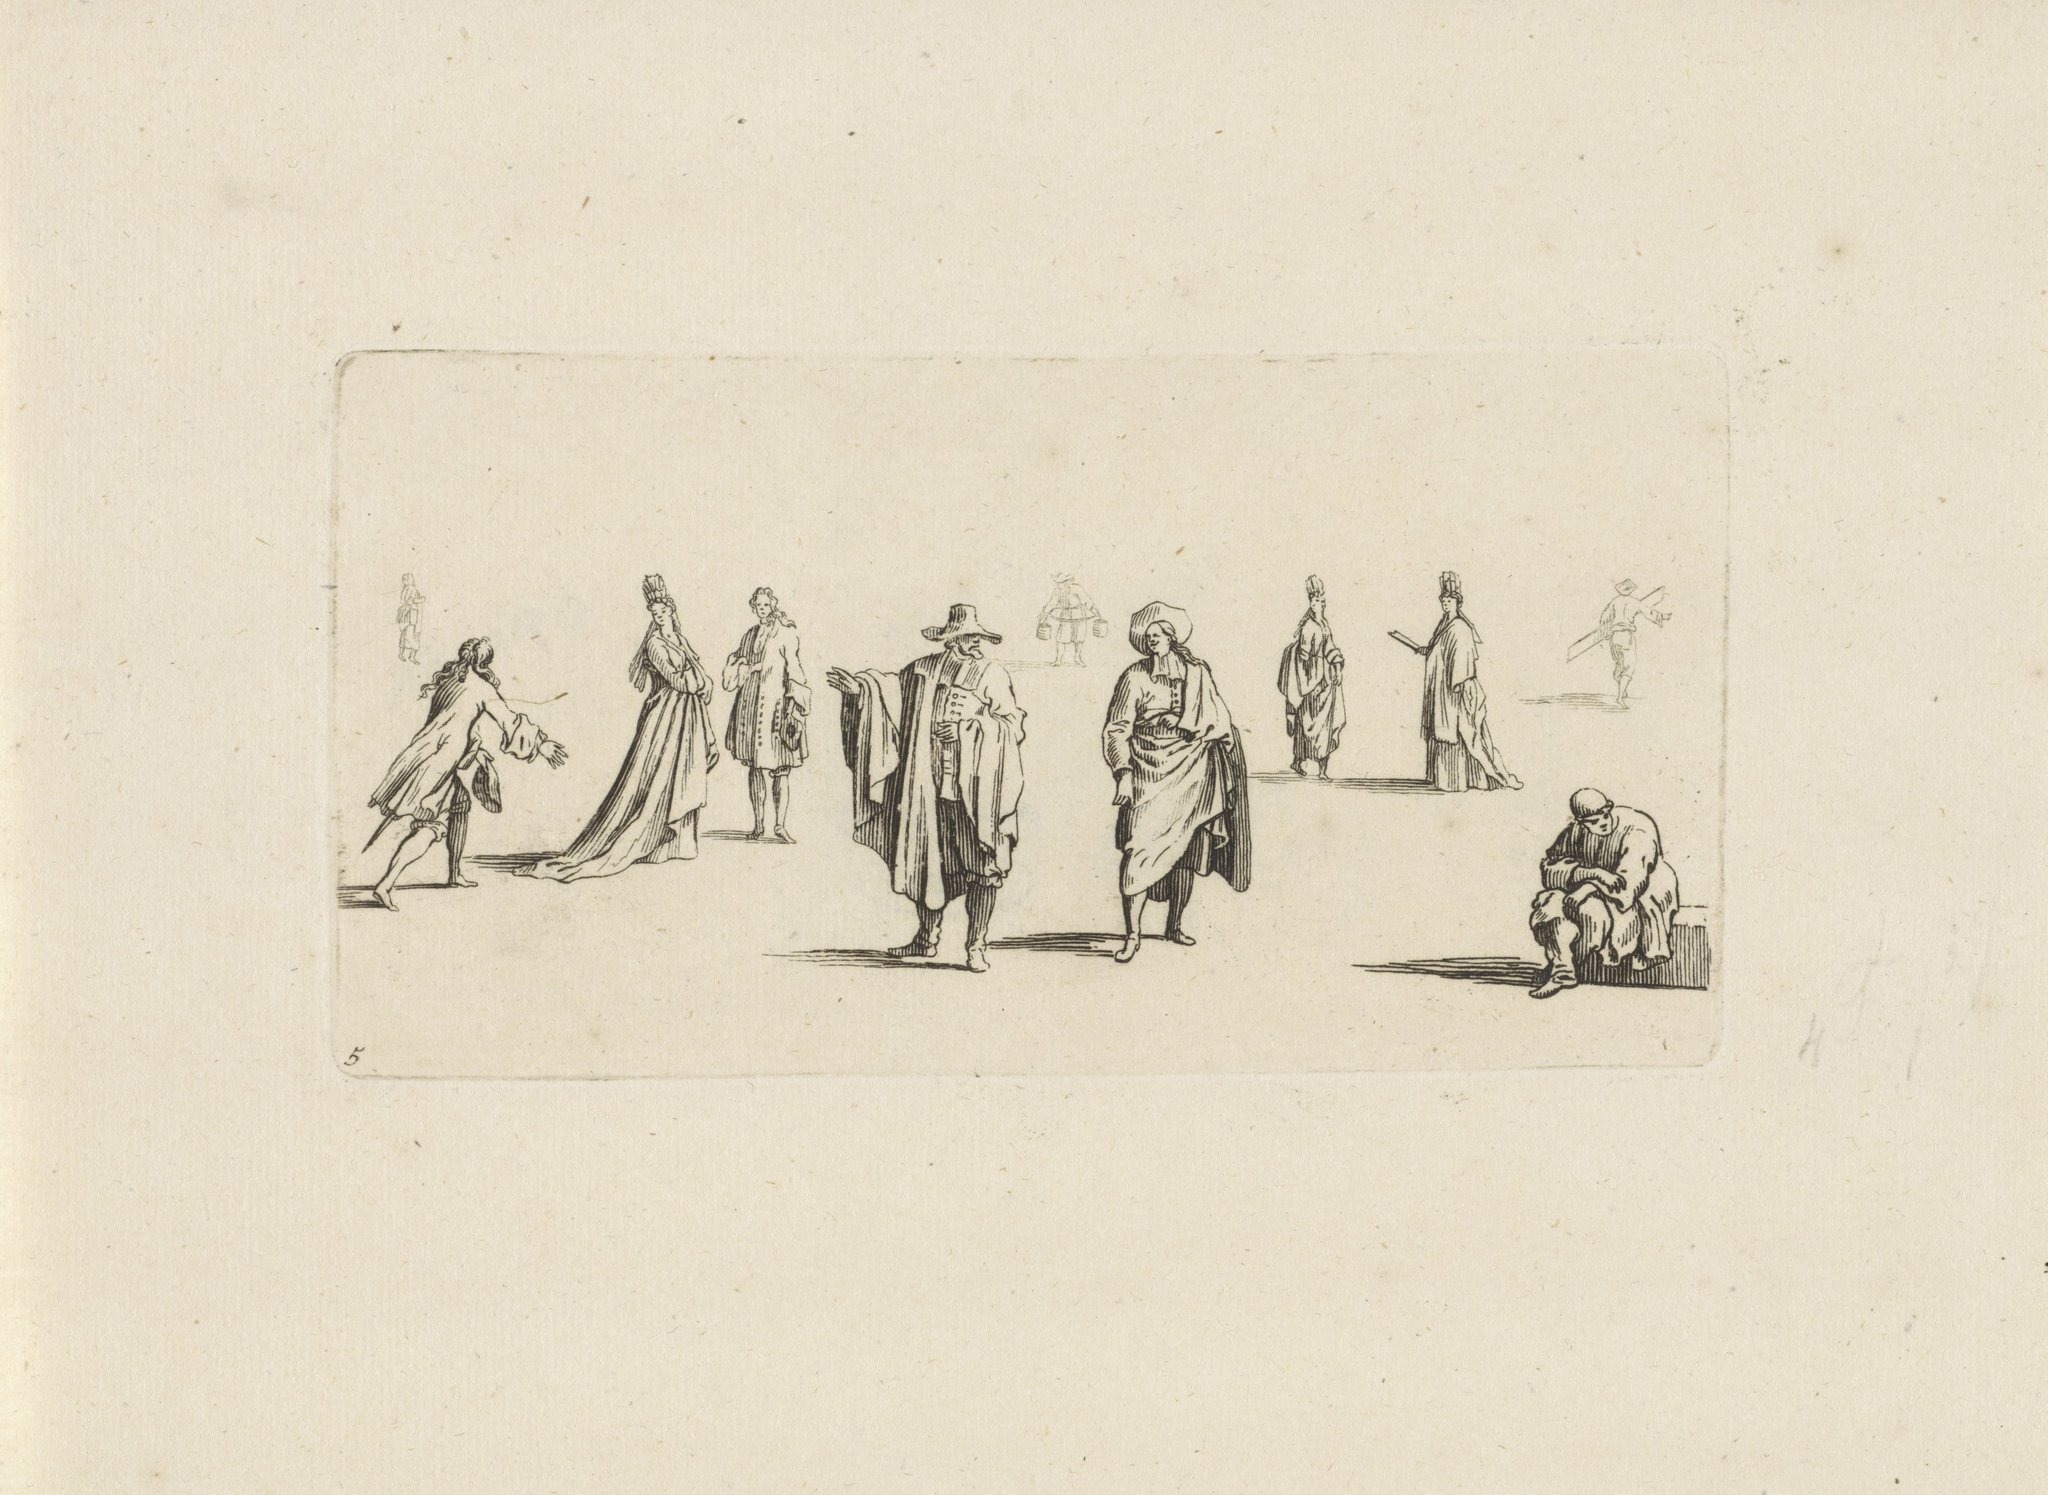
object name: print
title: Studieblad met zittende en staande figuren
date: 1675-1711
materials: paper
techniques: etching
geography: amsterdam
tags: human types; peoples and nationalities, head-gear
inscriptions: collector's mark: Lugt 2228